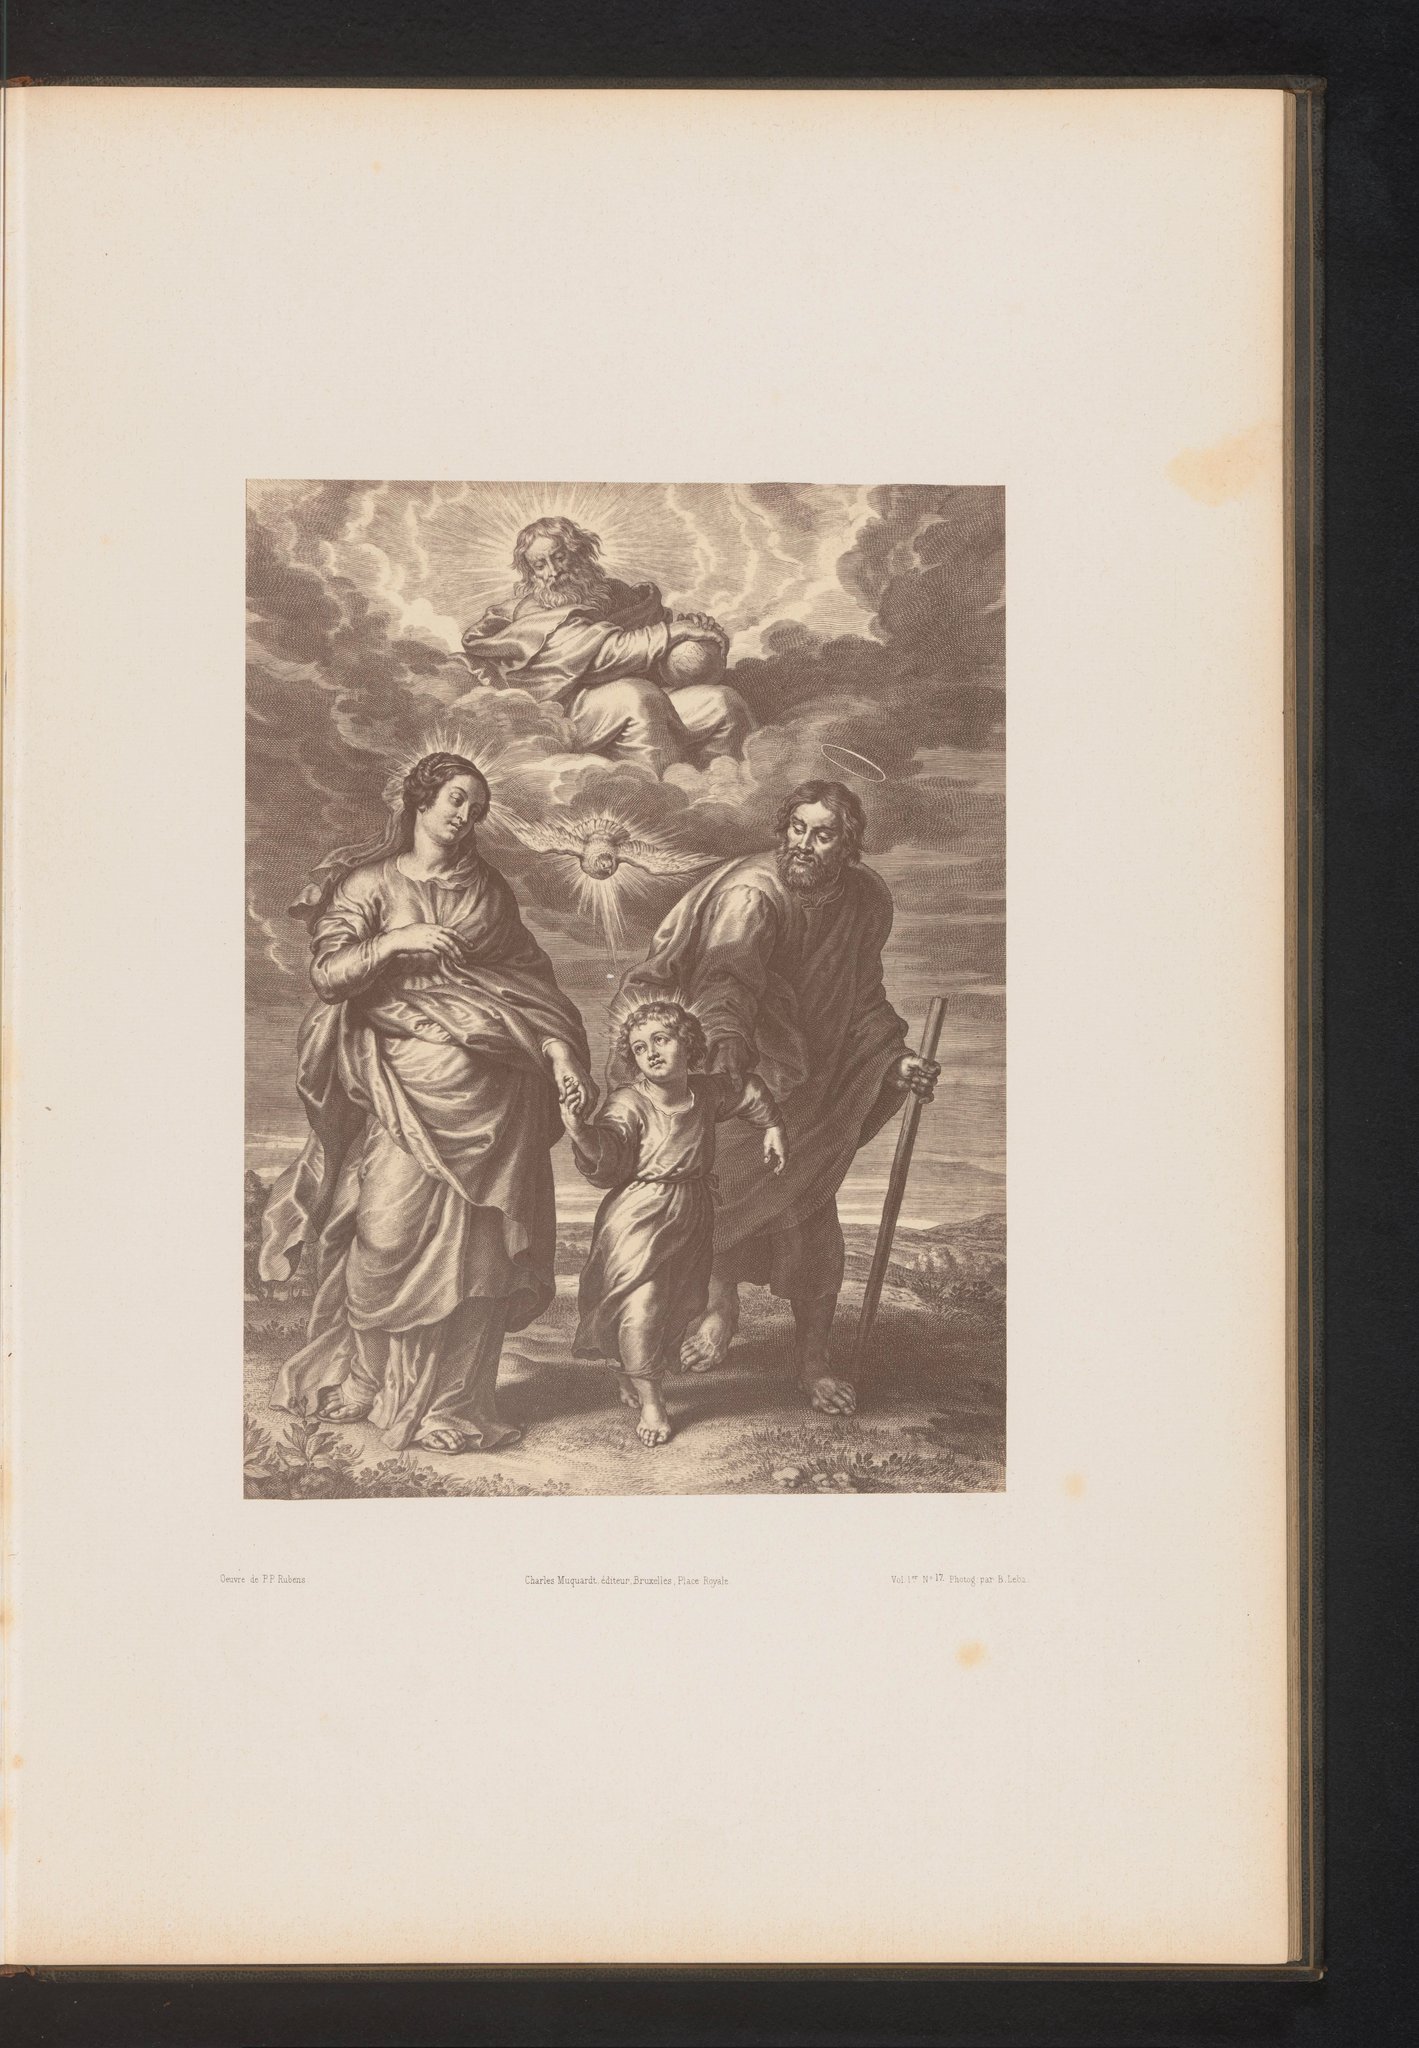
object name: photograph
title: Oeuvre de P.P. Rubens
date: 1853-1858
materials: photographic support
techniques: albumen print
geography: brussels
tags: the holy family (and sometimes others) returning to israel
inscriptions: number: ‘Vol. 1er. No 17.’